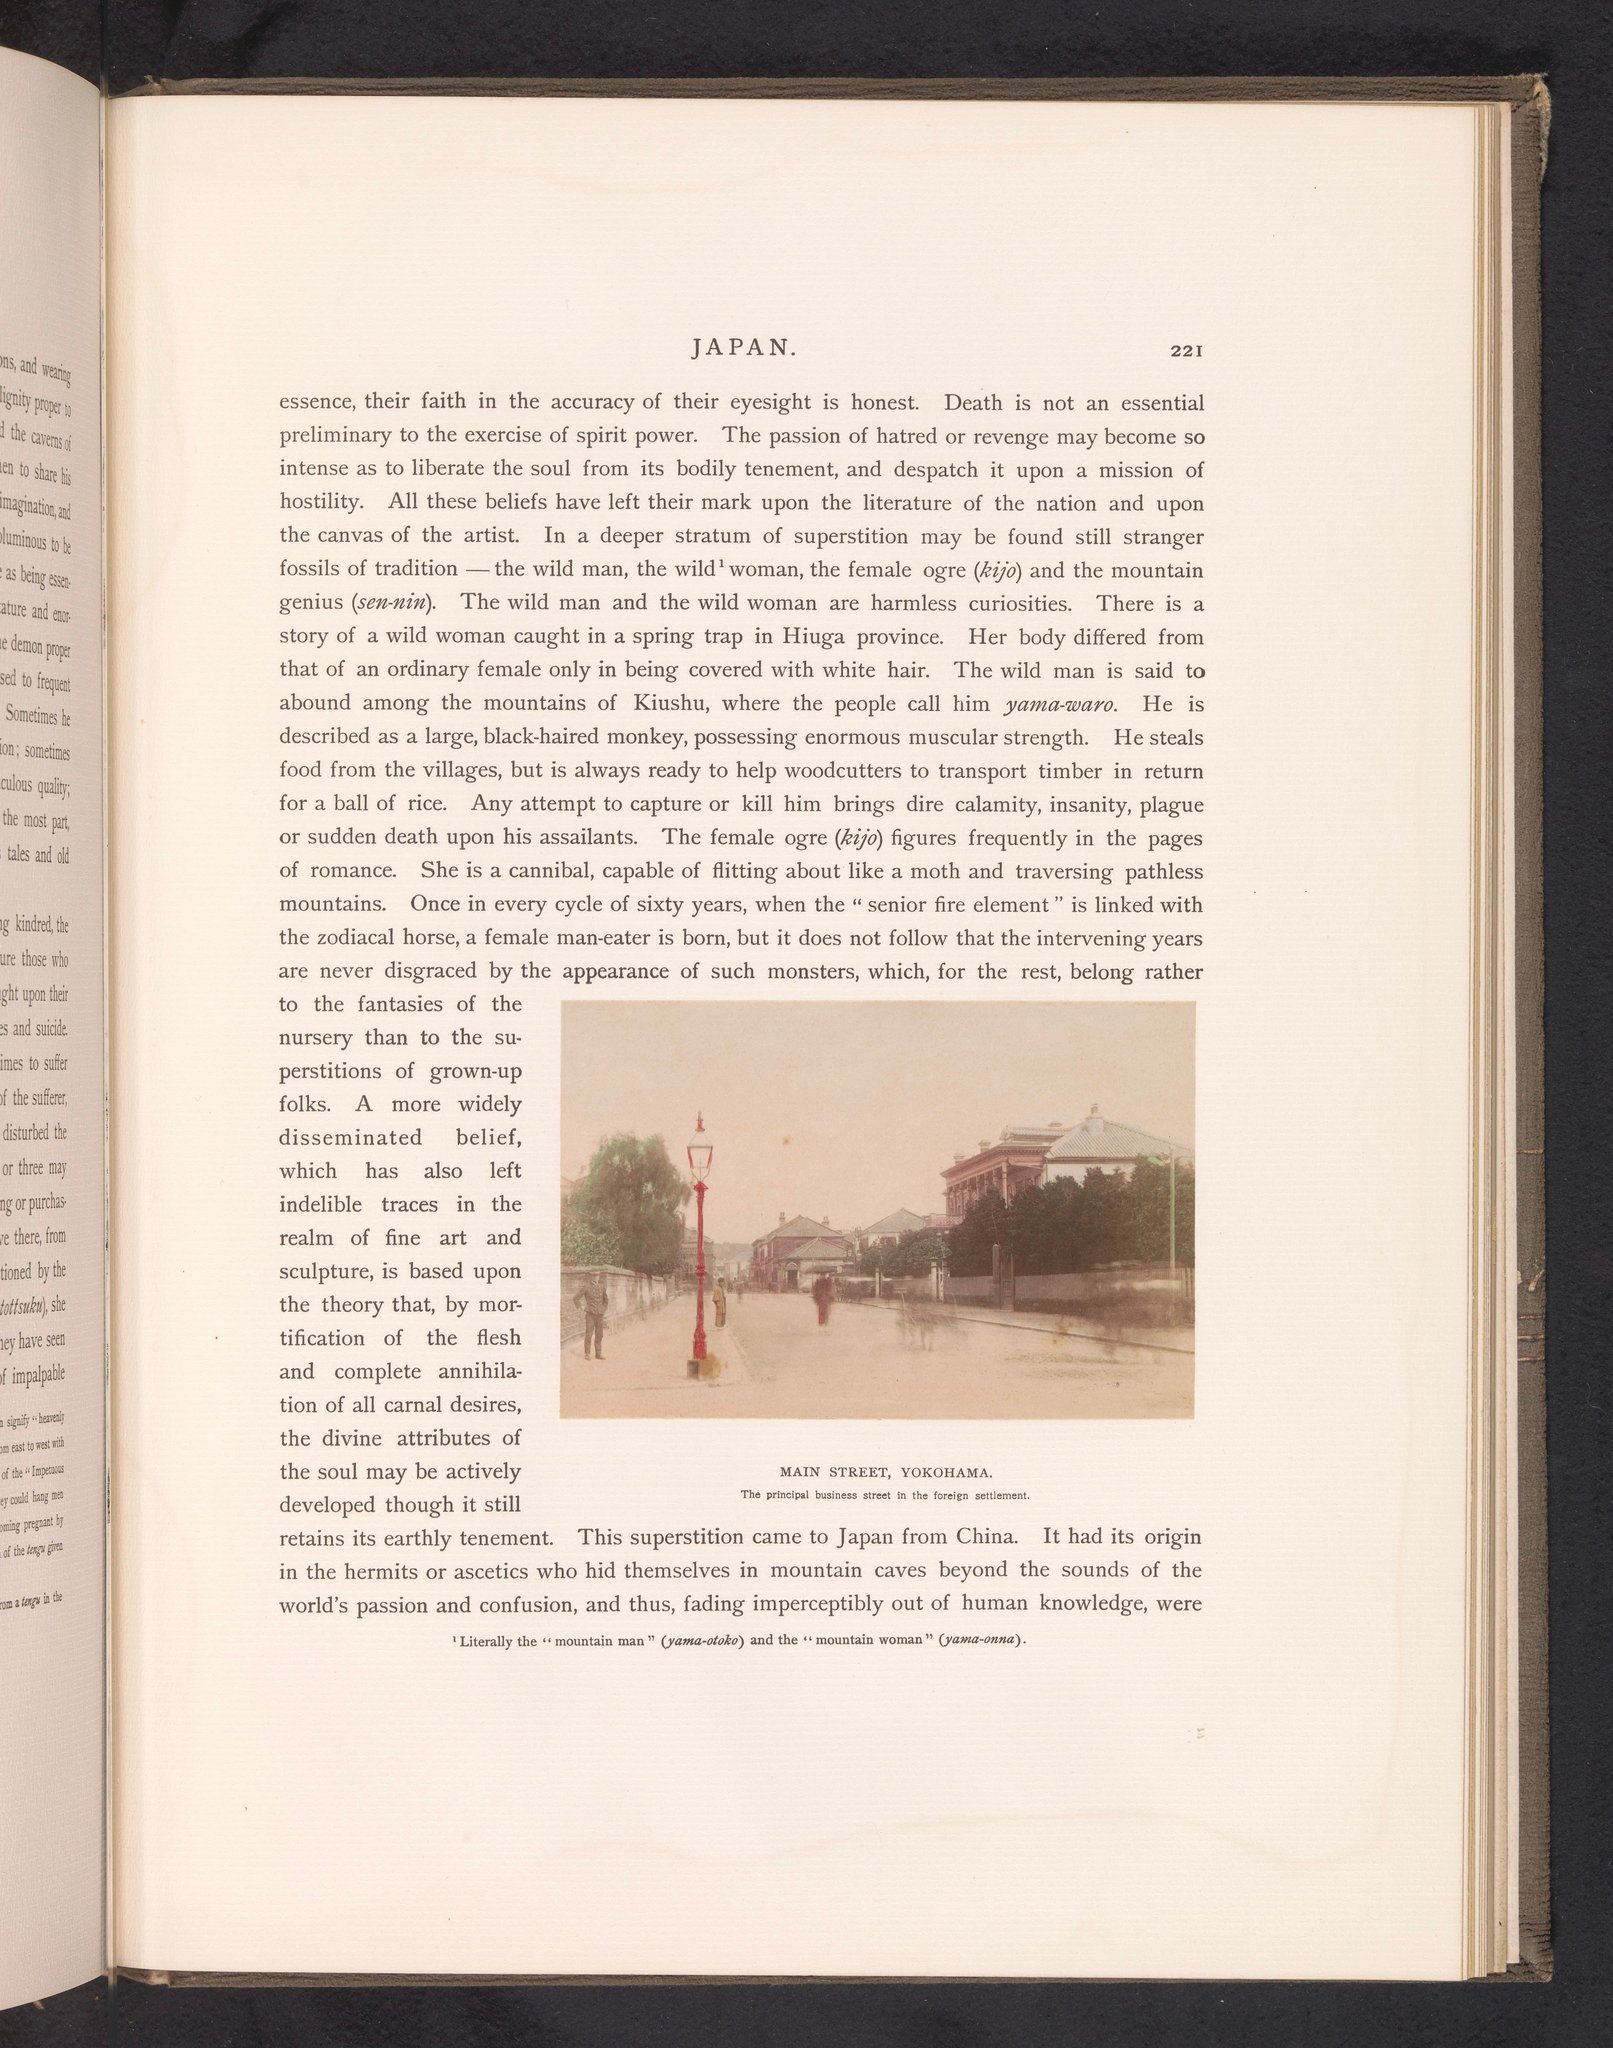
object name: photograph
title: Main street, Yokohama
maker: Anonymous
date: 1887-1897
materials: photographic support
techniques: albumen print, hand coloring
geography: yokohama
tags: street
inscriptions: inscription: ‘The principal business street in the foreign settlement.’